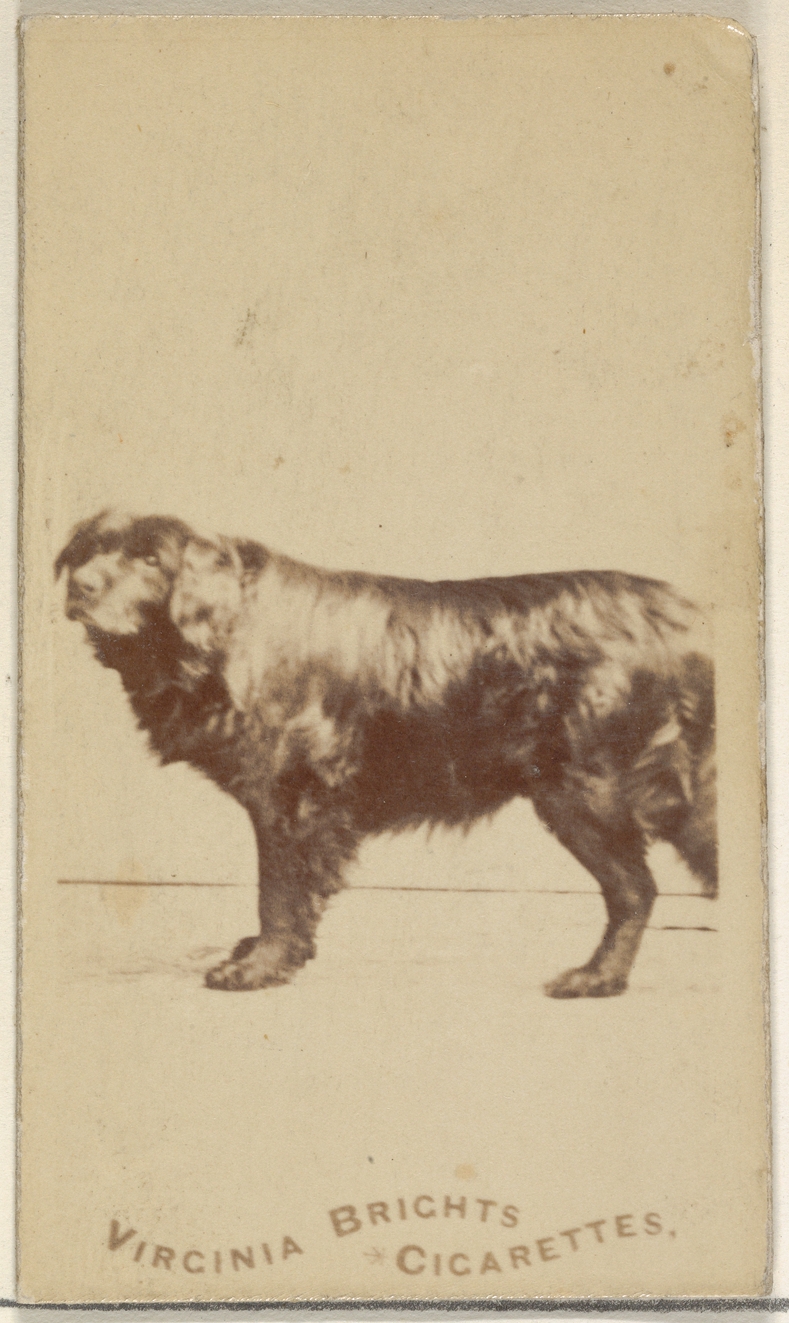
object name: photograph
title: From the Dogs series (N47) for Virginia Brights Cigarettes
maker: allen & ginter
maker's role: publisher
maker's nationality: american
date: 1888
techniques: albumen silver print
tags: dogs